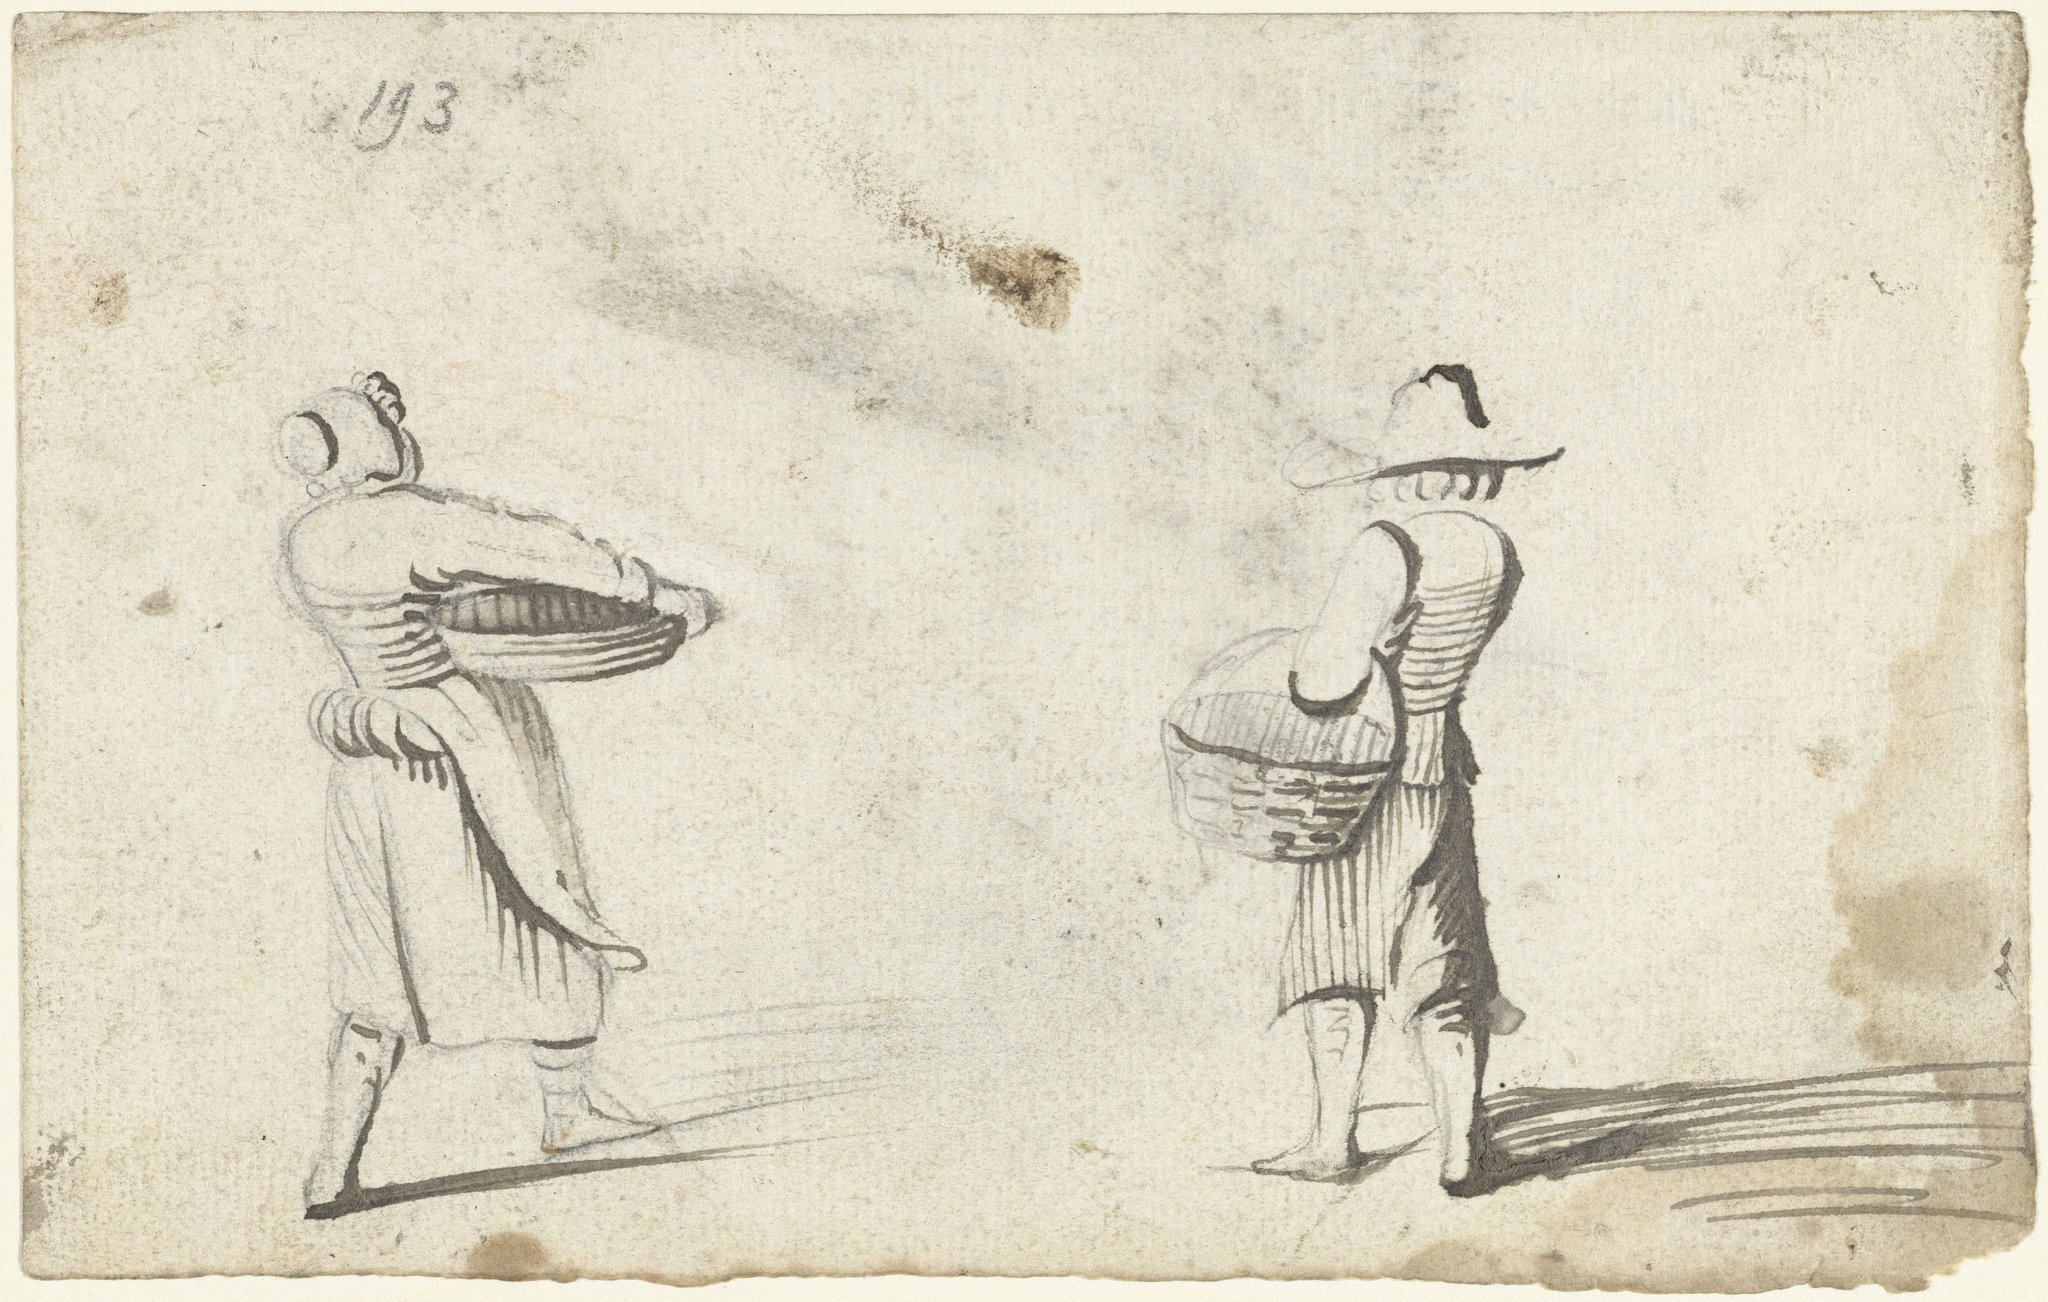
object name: drawing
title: Vrouw met schaal en man met mand, van achteren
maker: harmen ter borch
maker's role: draughtsman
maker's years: 1638-1677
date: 1650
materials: ink, paper, pencil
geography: zwolle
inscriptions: annotation: ‘Barent van Jerusalem demonstrande’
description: Studieblad met een vrouw die een schaal draagt en een man met een mand aan de arm.